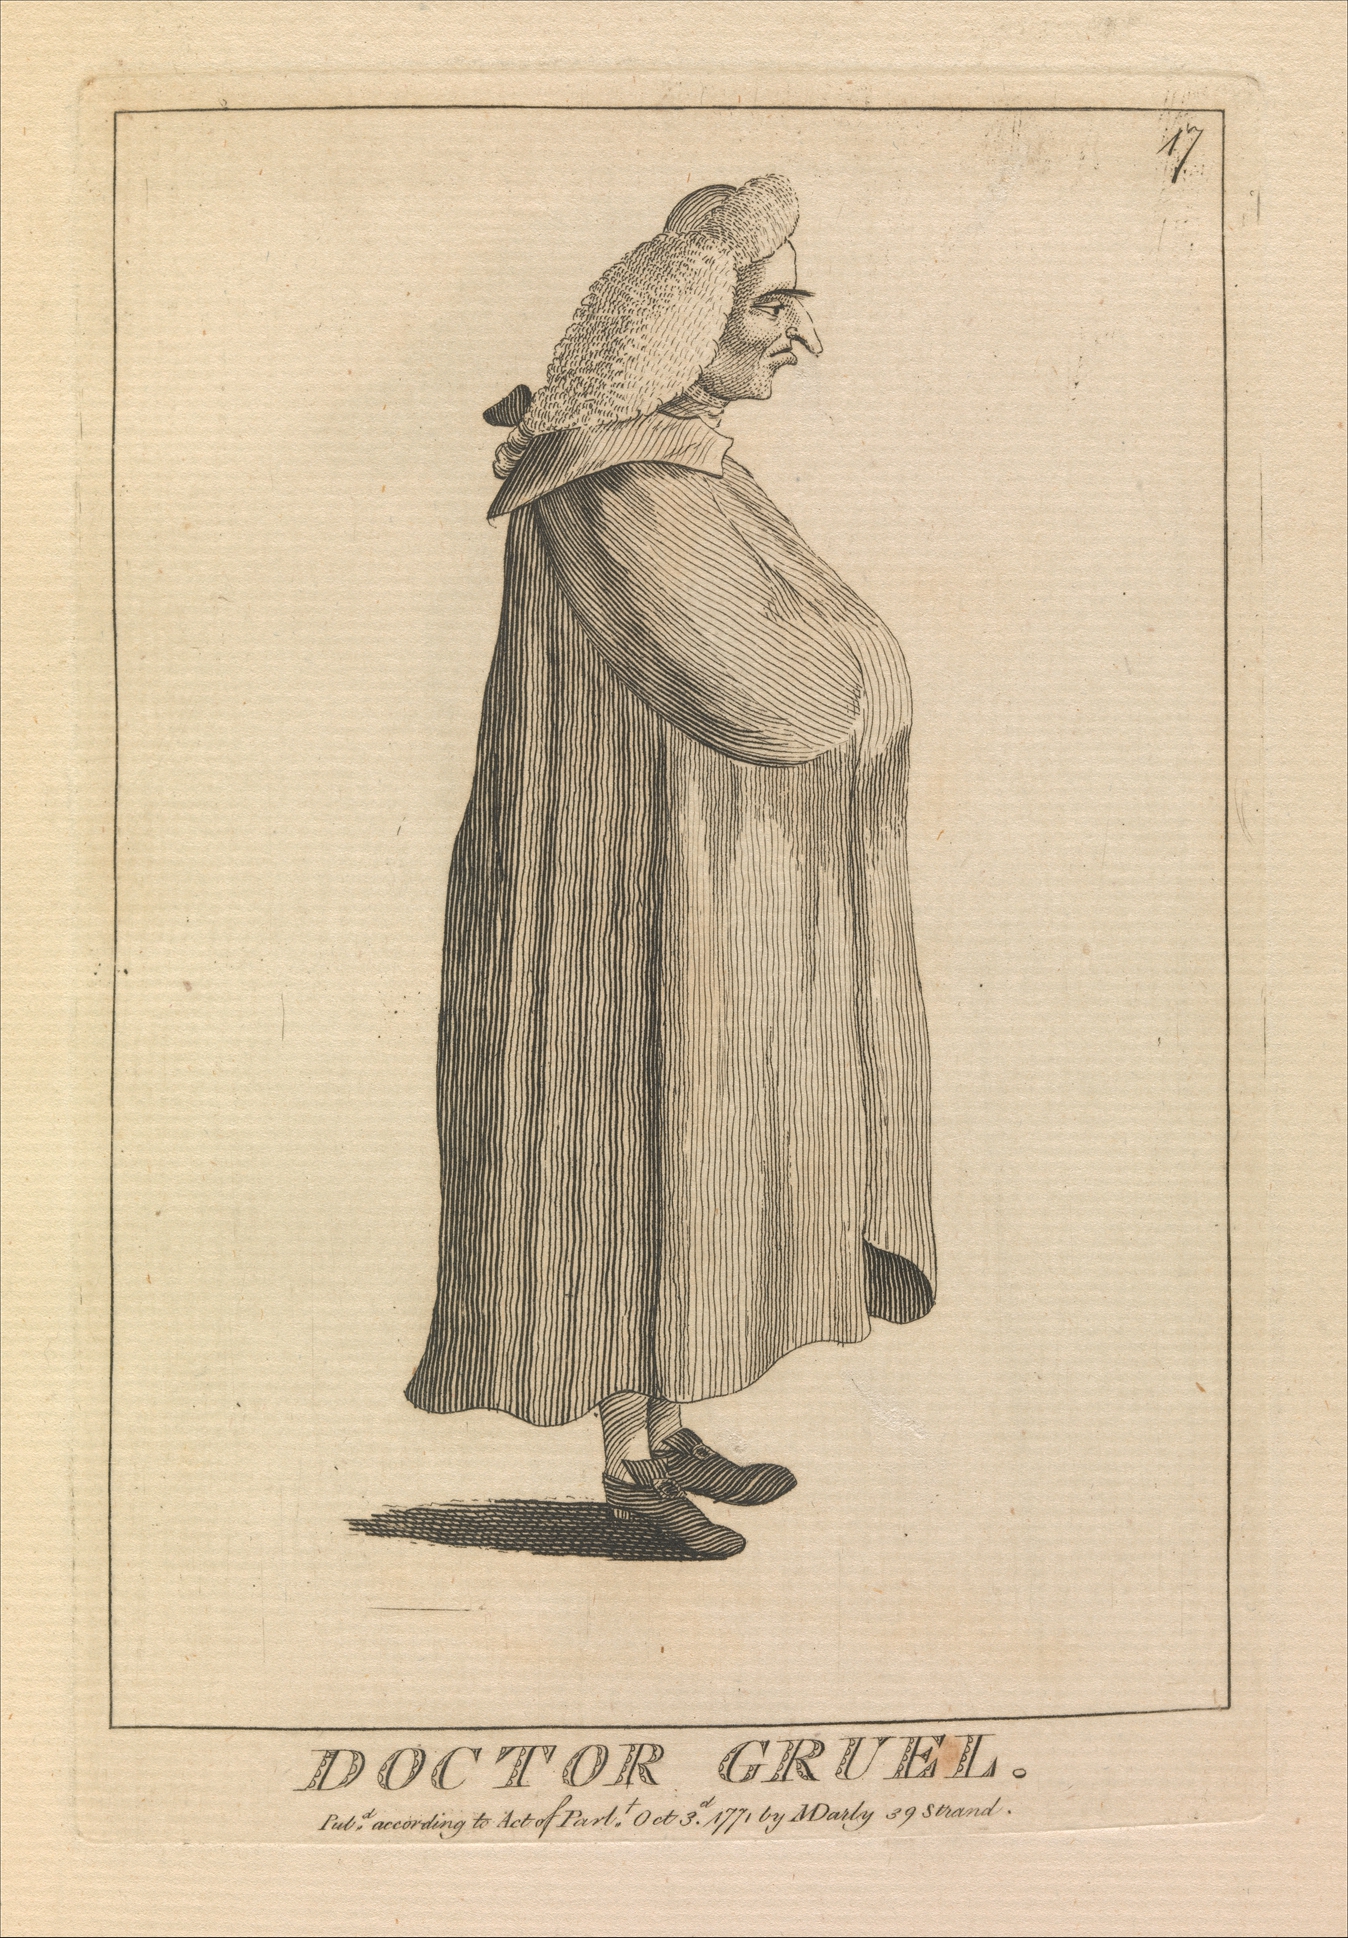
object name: print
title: Doctor Gruel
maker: matthias darly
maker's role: publisher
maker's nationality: british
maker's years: 1720-1780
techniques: etching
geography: london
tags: men,profiles